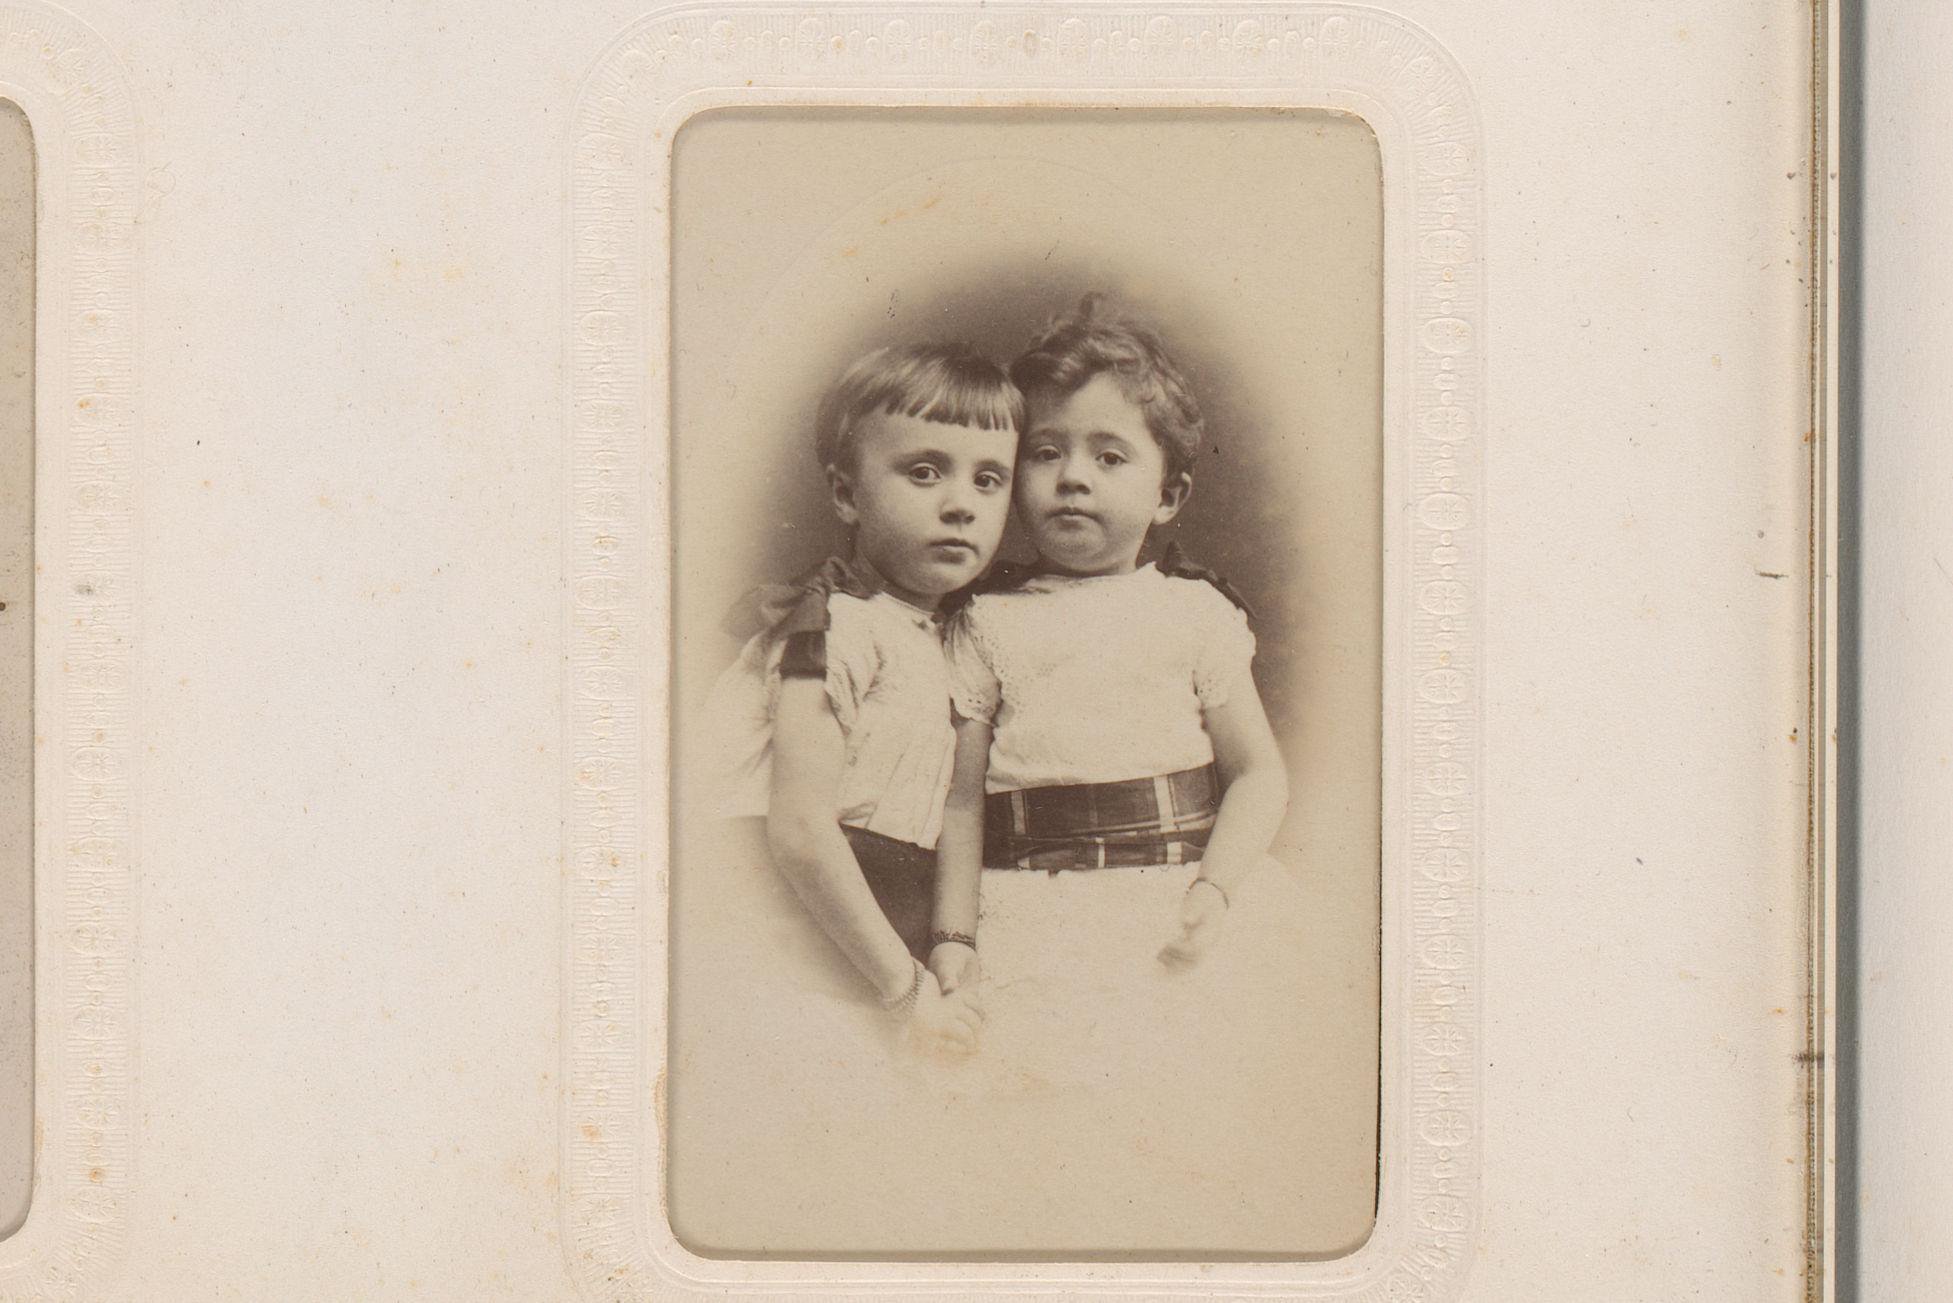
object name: album leaf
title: Portret van een baby met witte muts op een standaard omringd door bloemen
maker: Anonymous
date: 1860-1900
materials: cardboard, photographic support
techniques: albumen print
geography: netherlands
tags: historical persons, head-gear: cap, infant, baby ~ the ages of man